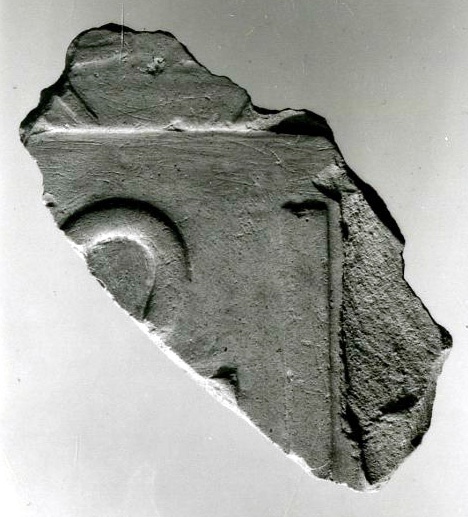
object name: relief fragment, tomb of meketre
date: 1981-1975 BCE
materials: limestone, paint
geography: egypt